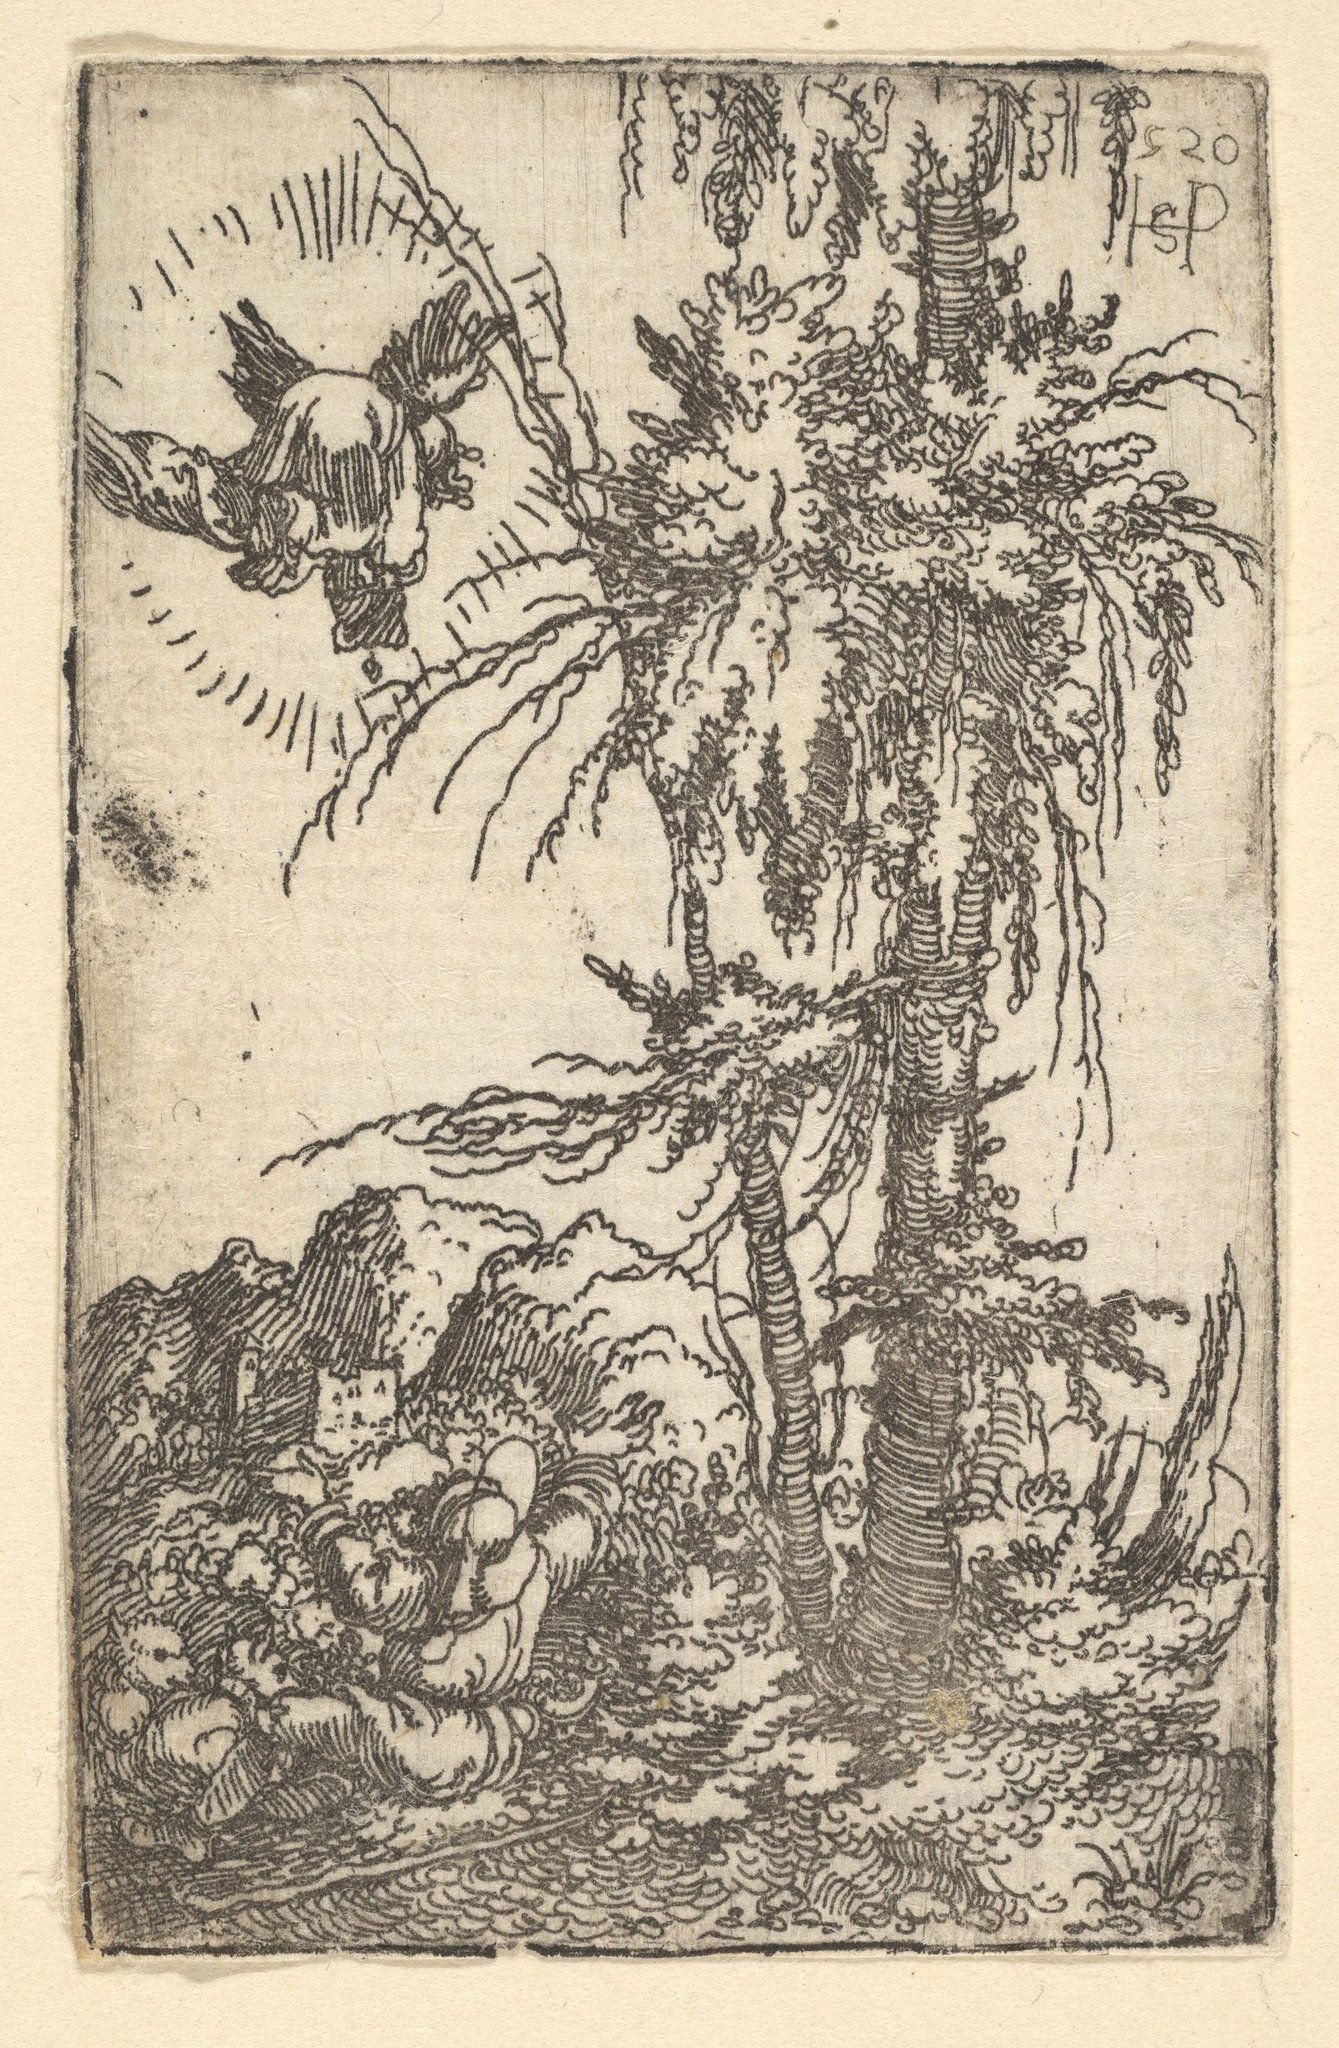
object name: print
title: Joachim Receiving the Promise of the Birth of the Virgin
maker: sebald beham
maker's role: artist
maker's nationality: german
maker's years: 1500-1550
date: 1520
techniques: etching